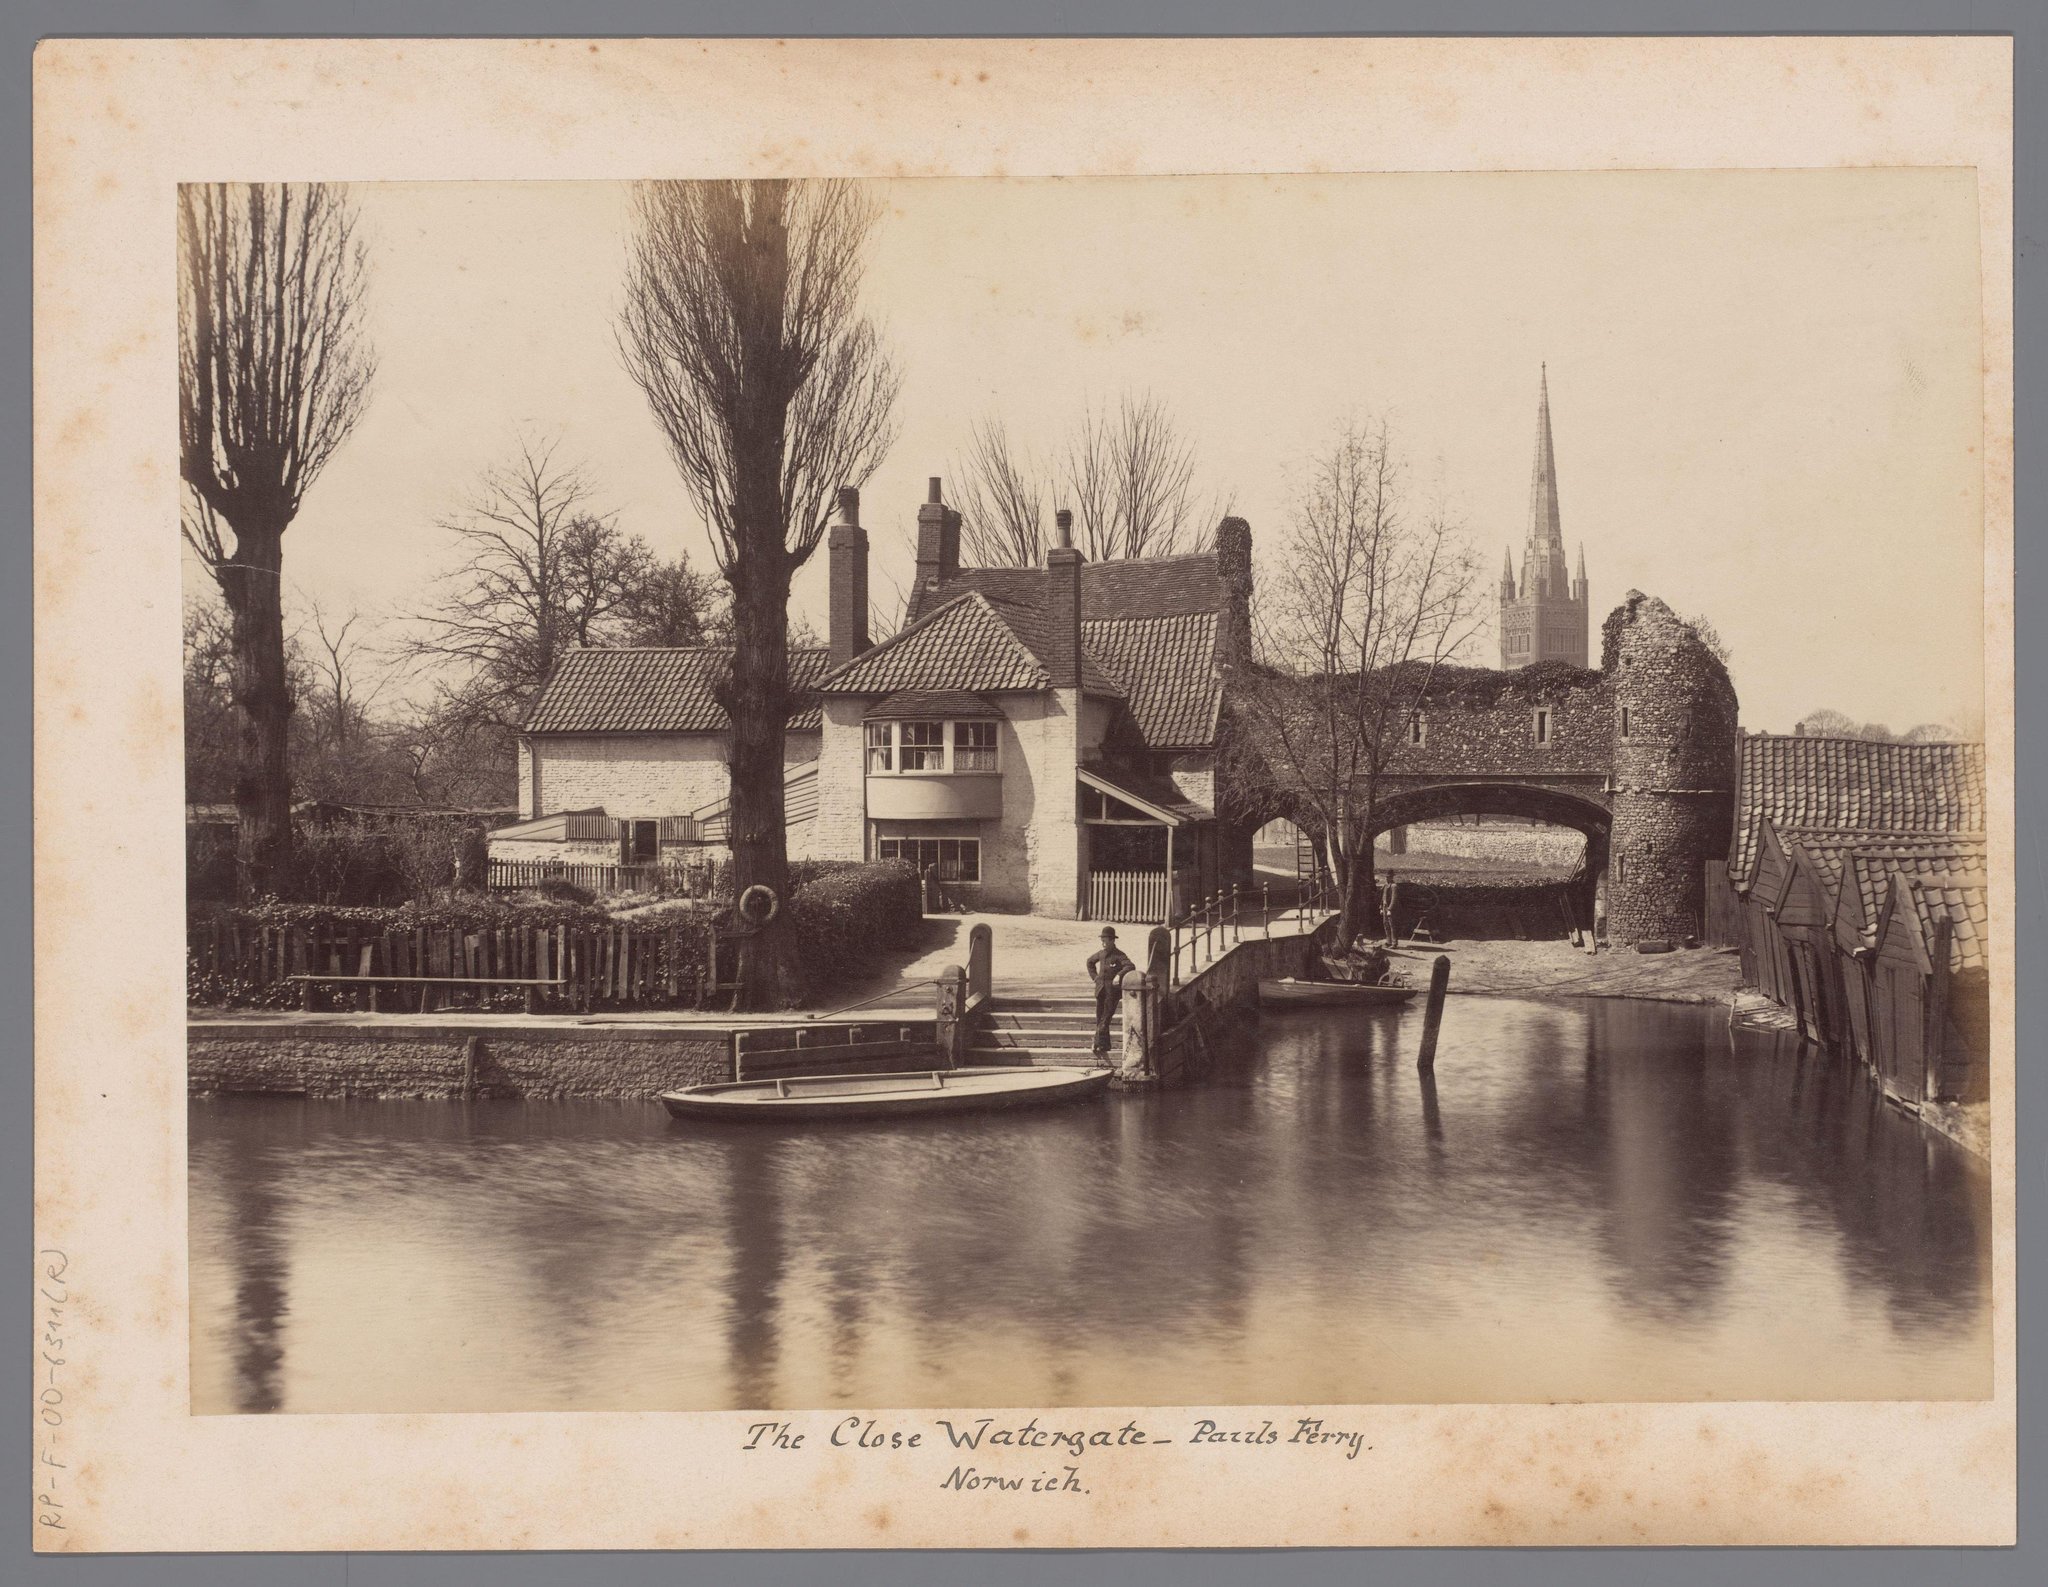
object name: album leaf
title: Landschap ["The Close Watergate - Pauls Ferry, Norwich"], Norwich, Engeland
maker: Anonymous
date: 1870-1900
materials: cardboard, paper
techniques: albumen print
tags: norwich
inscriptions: caption: ‘The Close Watergate - Pauls Ferry.//Norwich.’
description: Landschap met water en een bootje met een man aan wal ernaast. Rechts op de achtergrond een gedeelte van een oude poort met daarachter een kerktoren. Norwich is een Engelse stad en een district in het graafschap Norfolk aan de oostkust van Engeland.